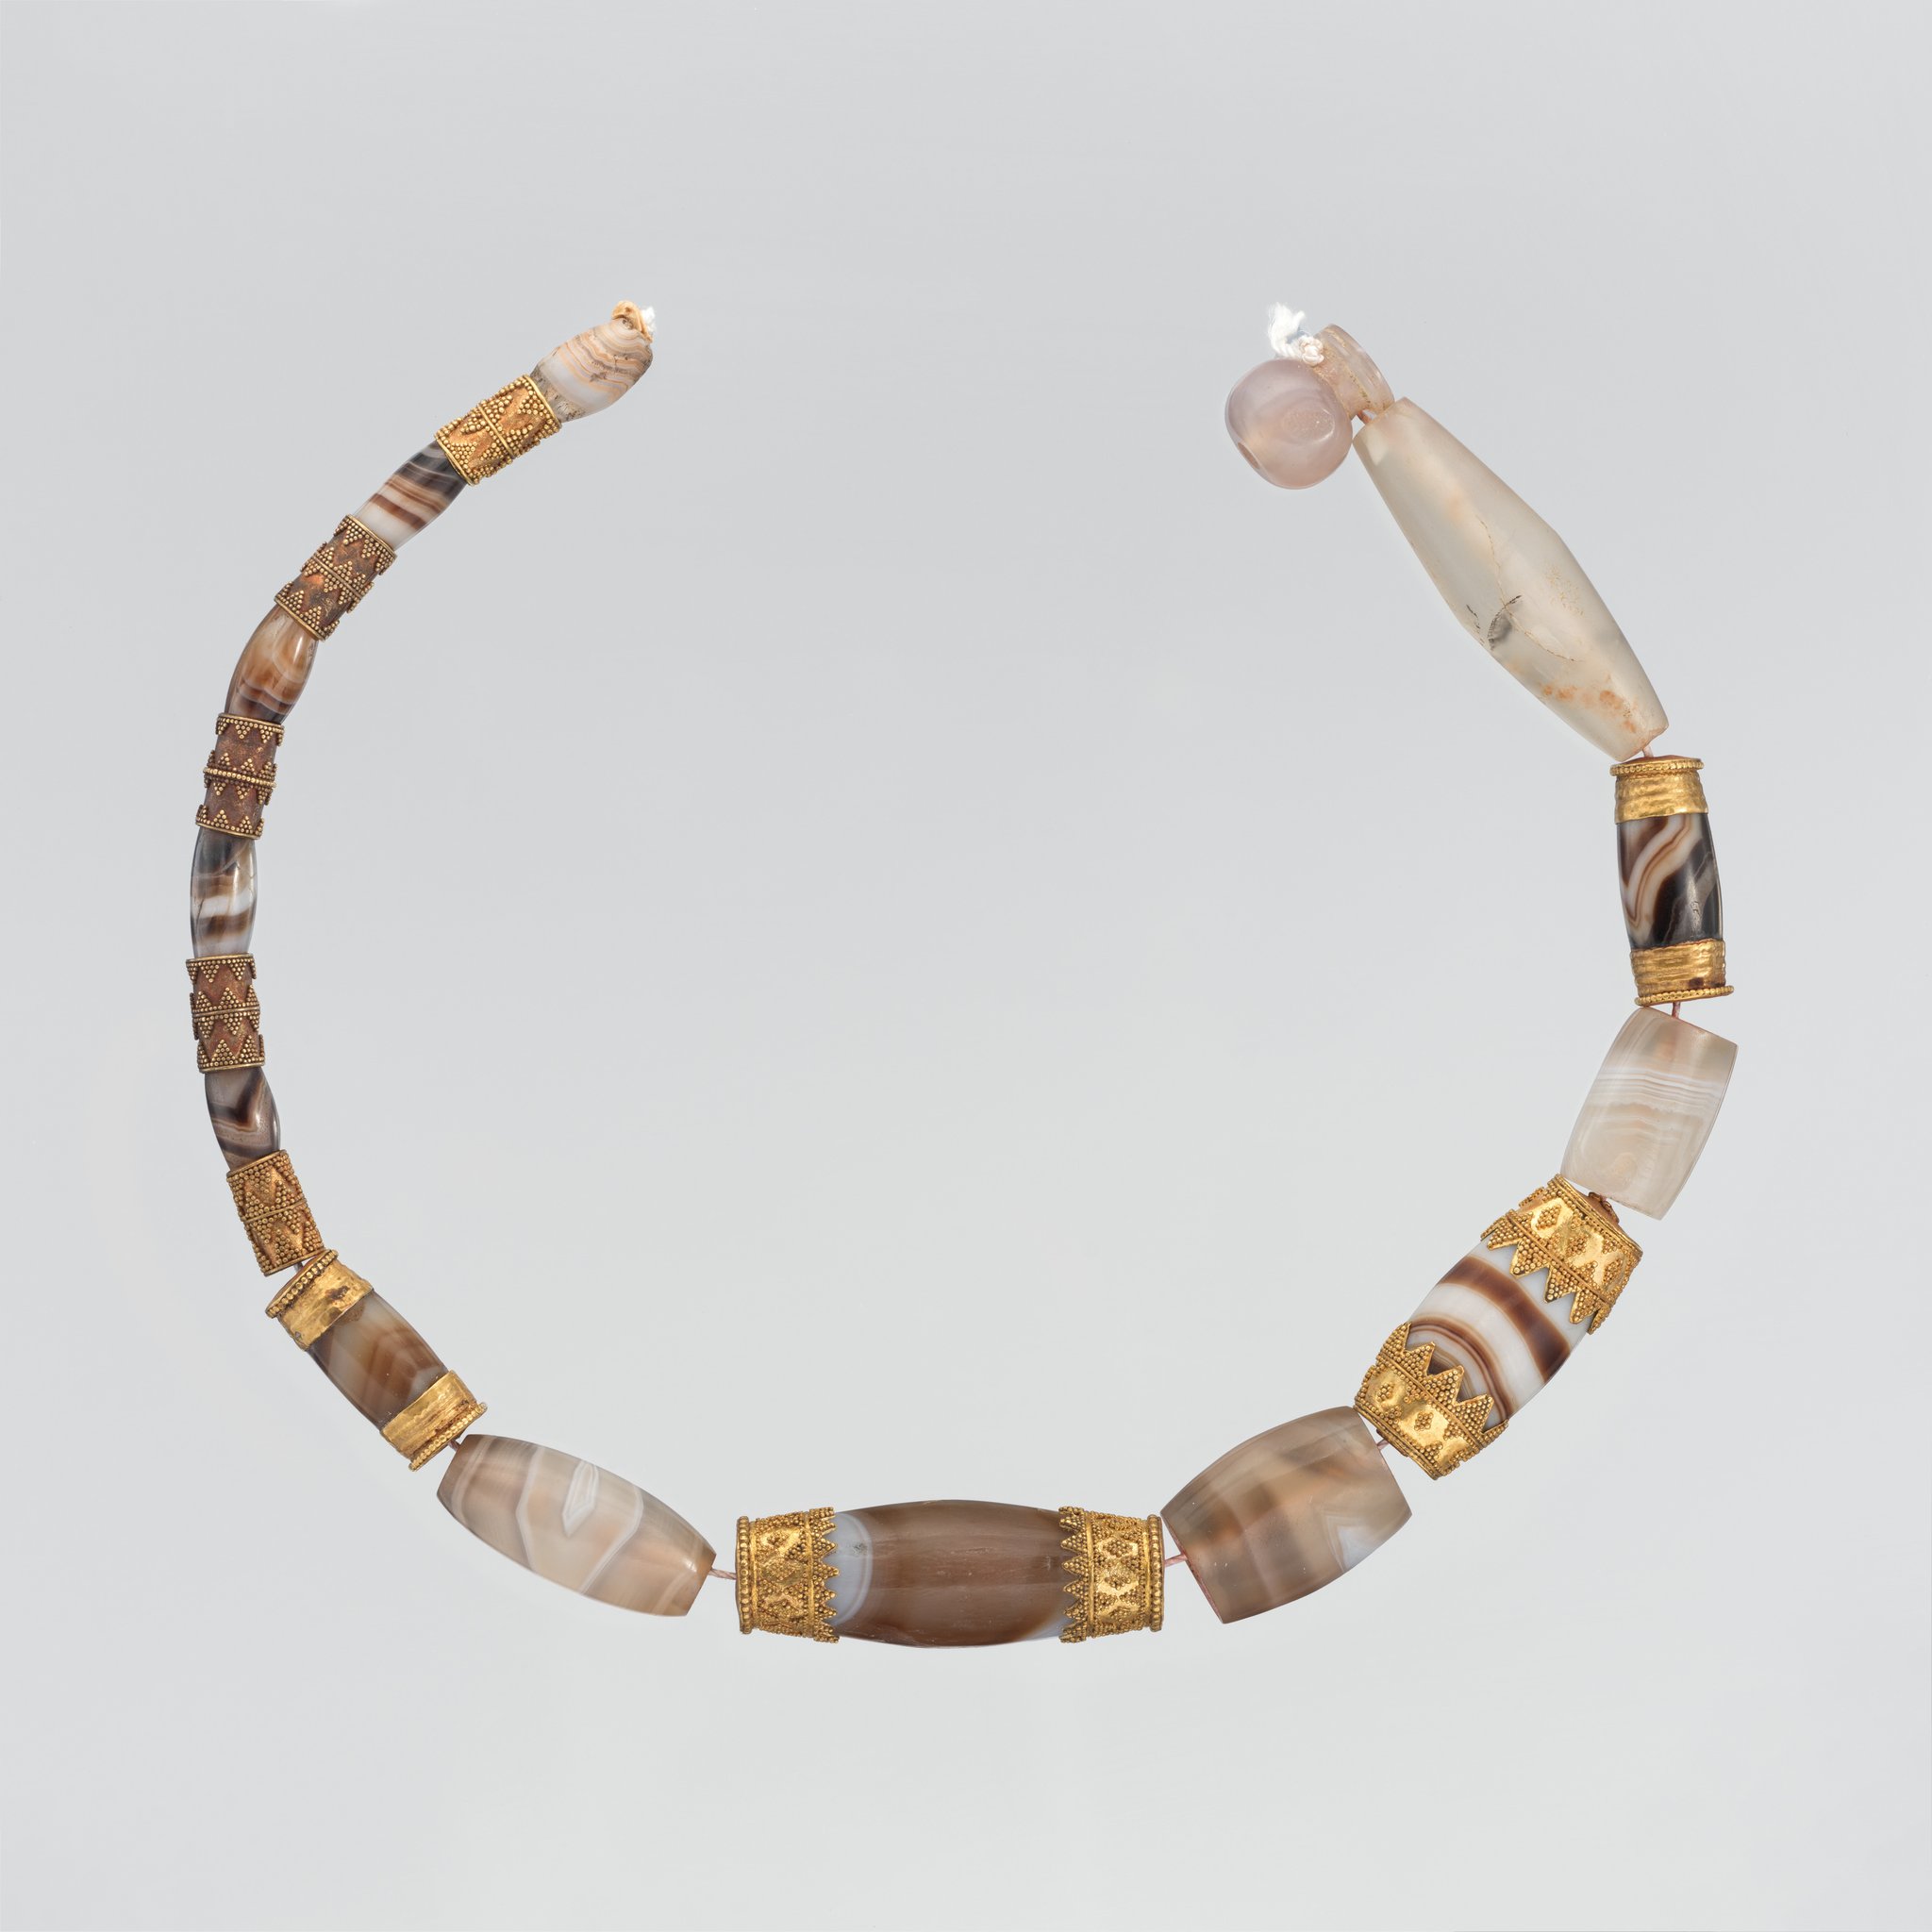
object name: bead of agate, chalcedony and gold mount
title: Necklace of banded agate, chalcedony, and gold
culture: cypriot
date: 700-601 BCE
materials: stone, gold